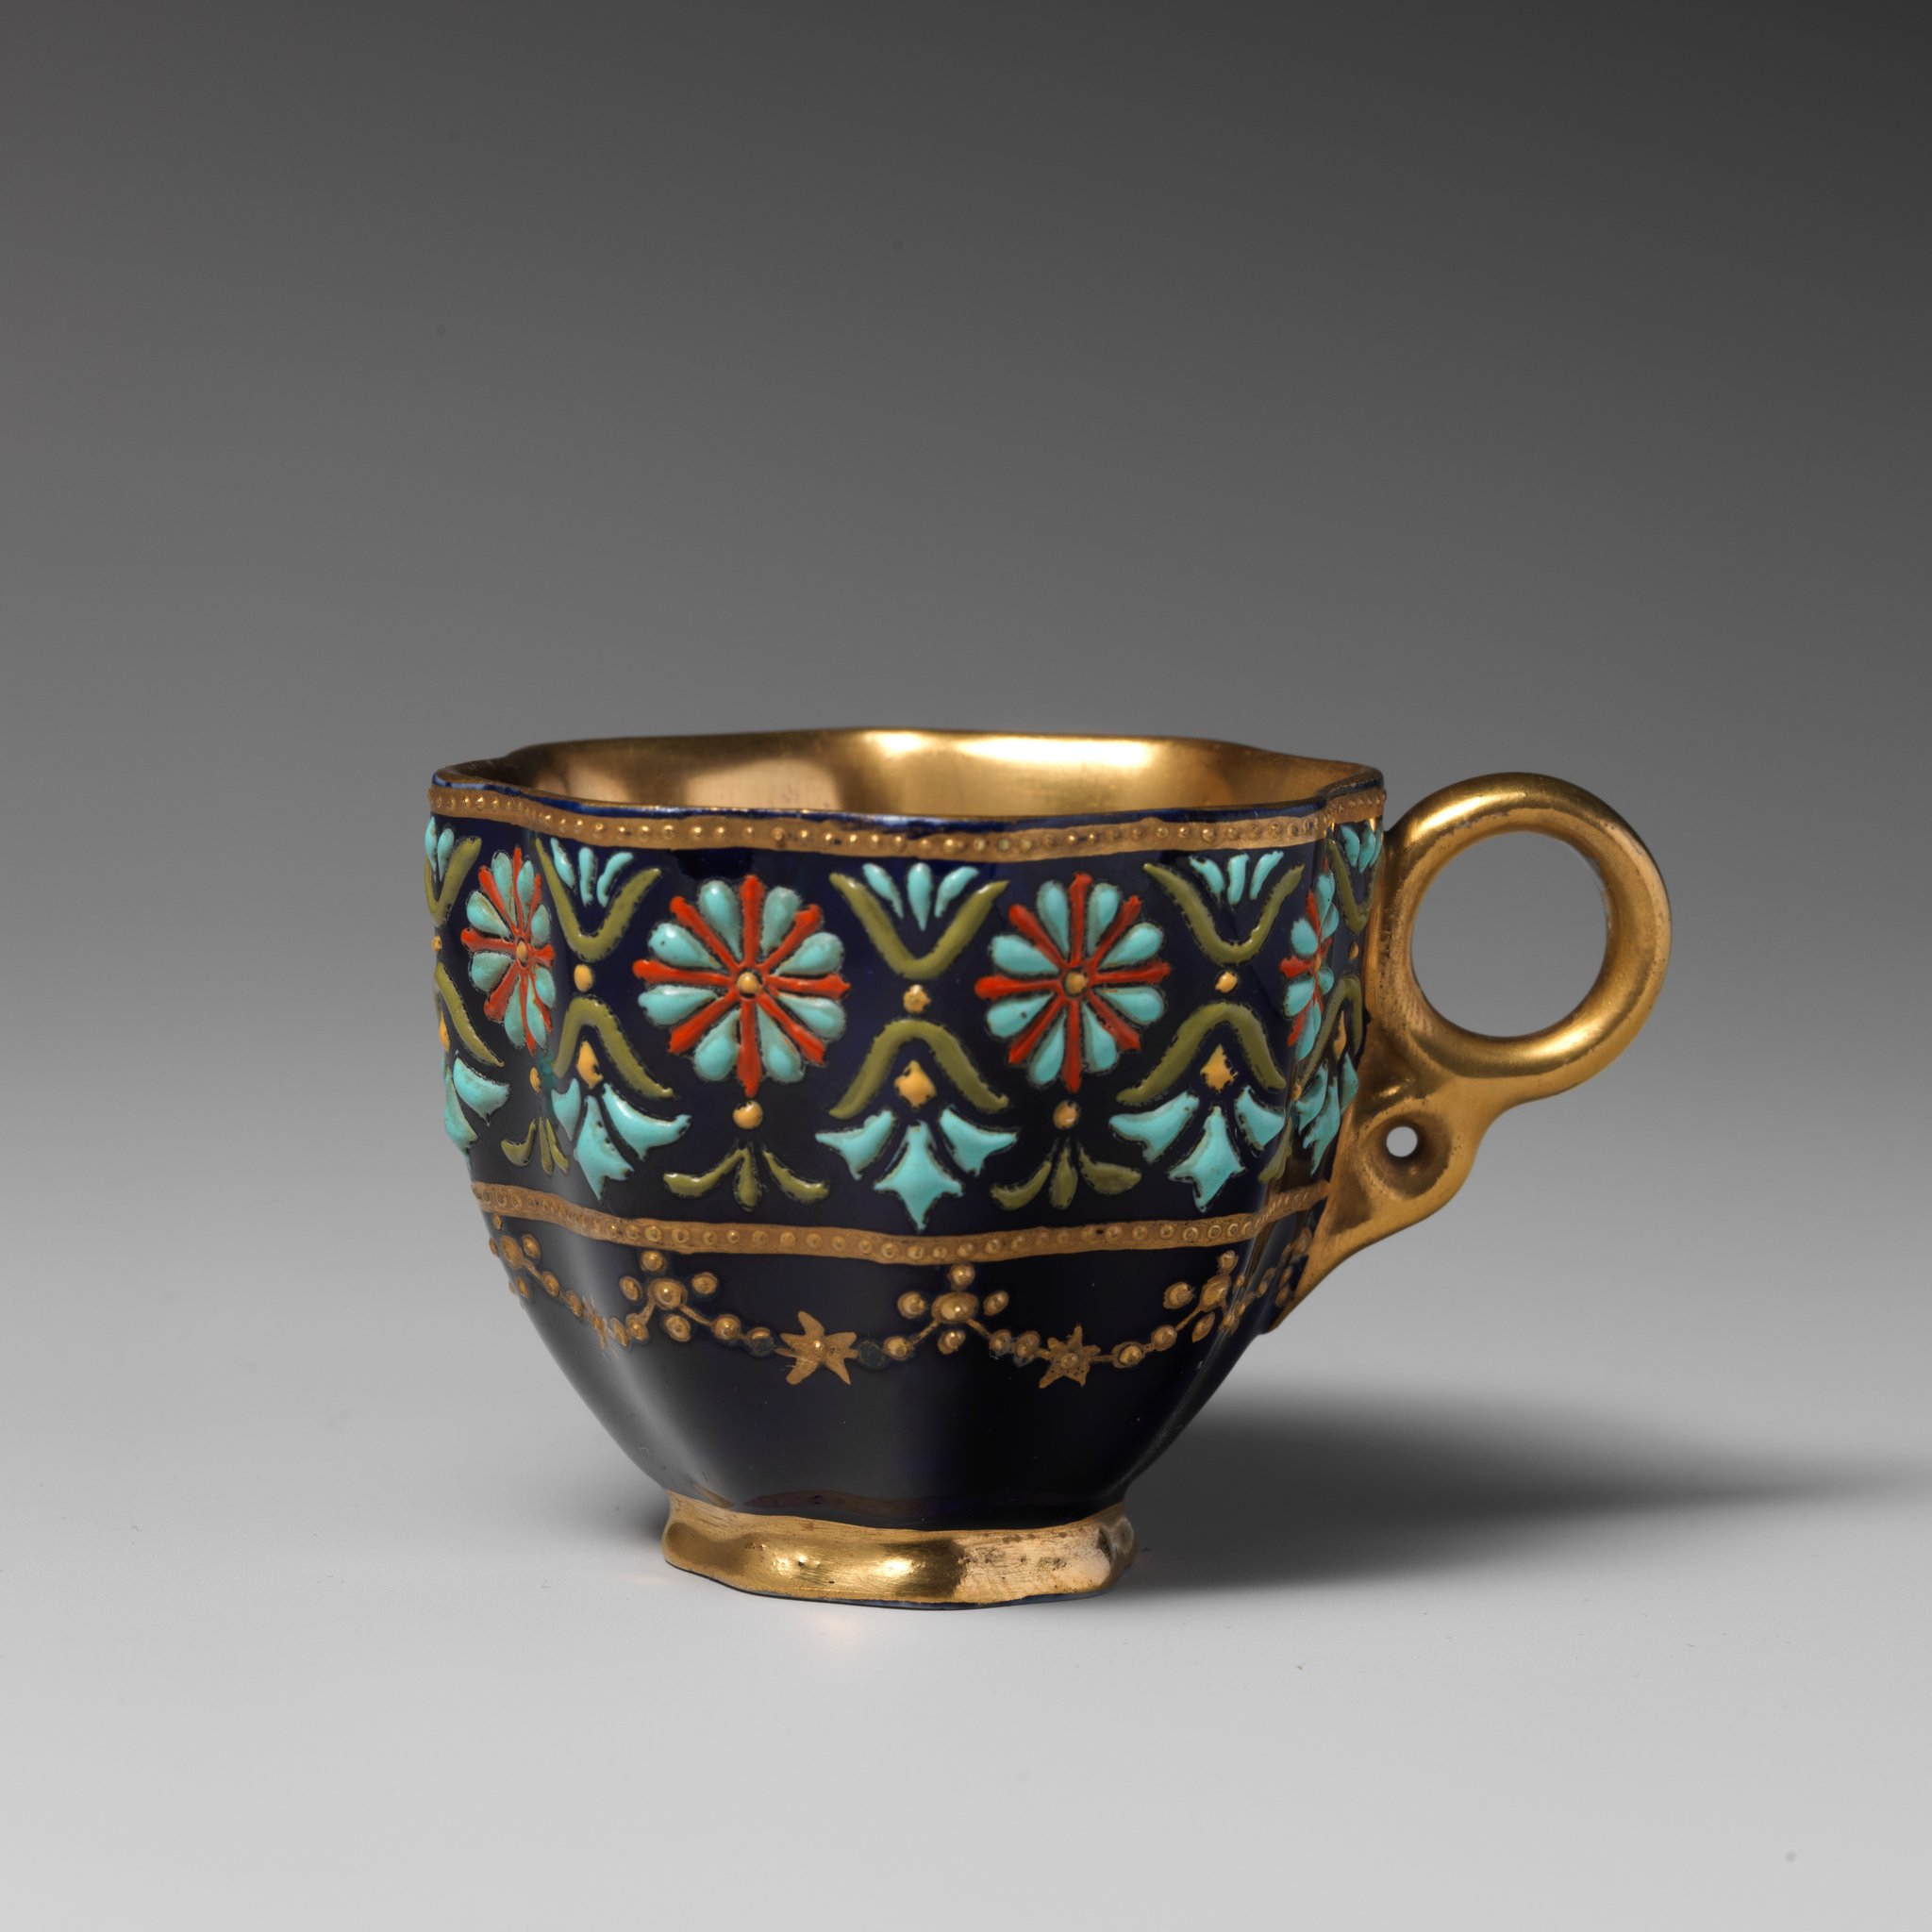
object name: teacup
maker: coalport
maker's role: maker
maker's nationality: british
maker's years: 1794-1926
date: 1881-1891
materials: porcelain